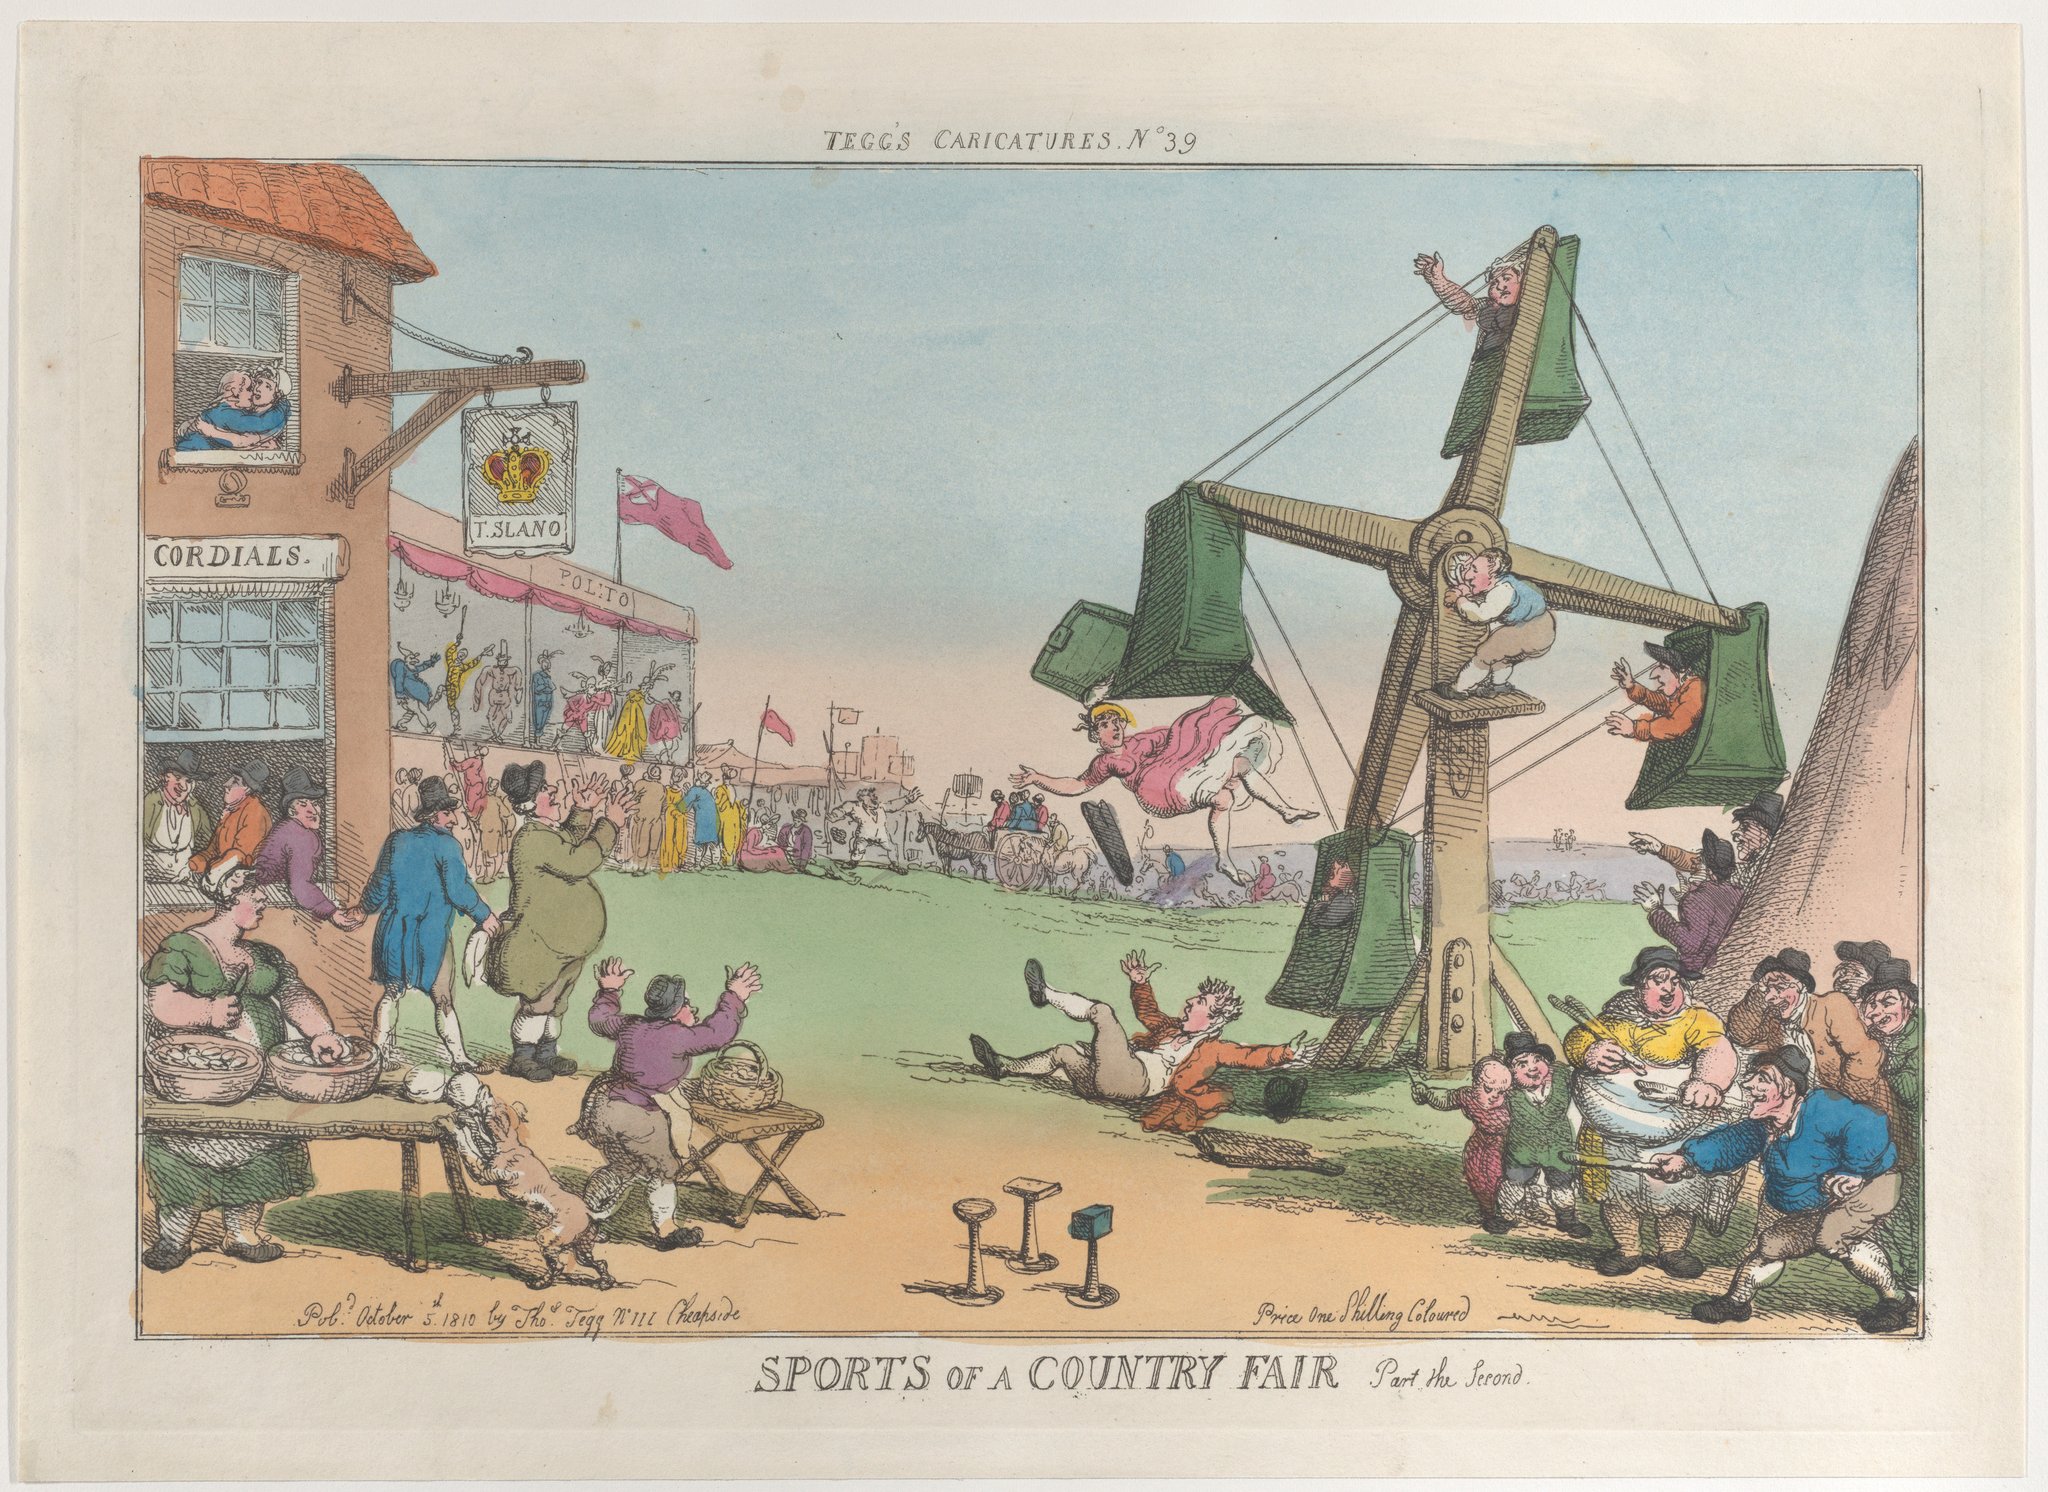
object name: print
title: Sports of a Country Fair, Part the Second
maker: thomas rowlandson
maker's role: artist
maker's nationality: british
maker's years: 1757-1827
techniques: etching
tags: leisure,men,women,spectators,caricature